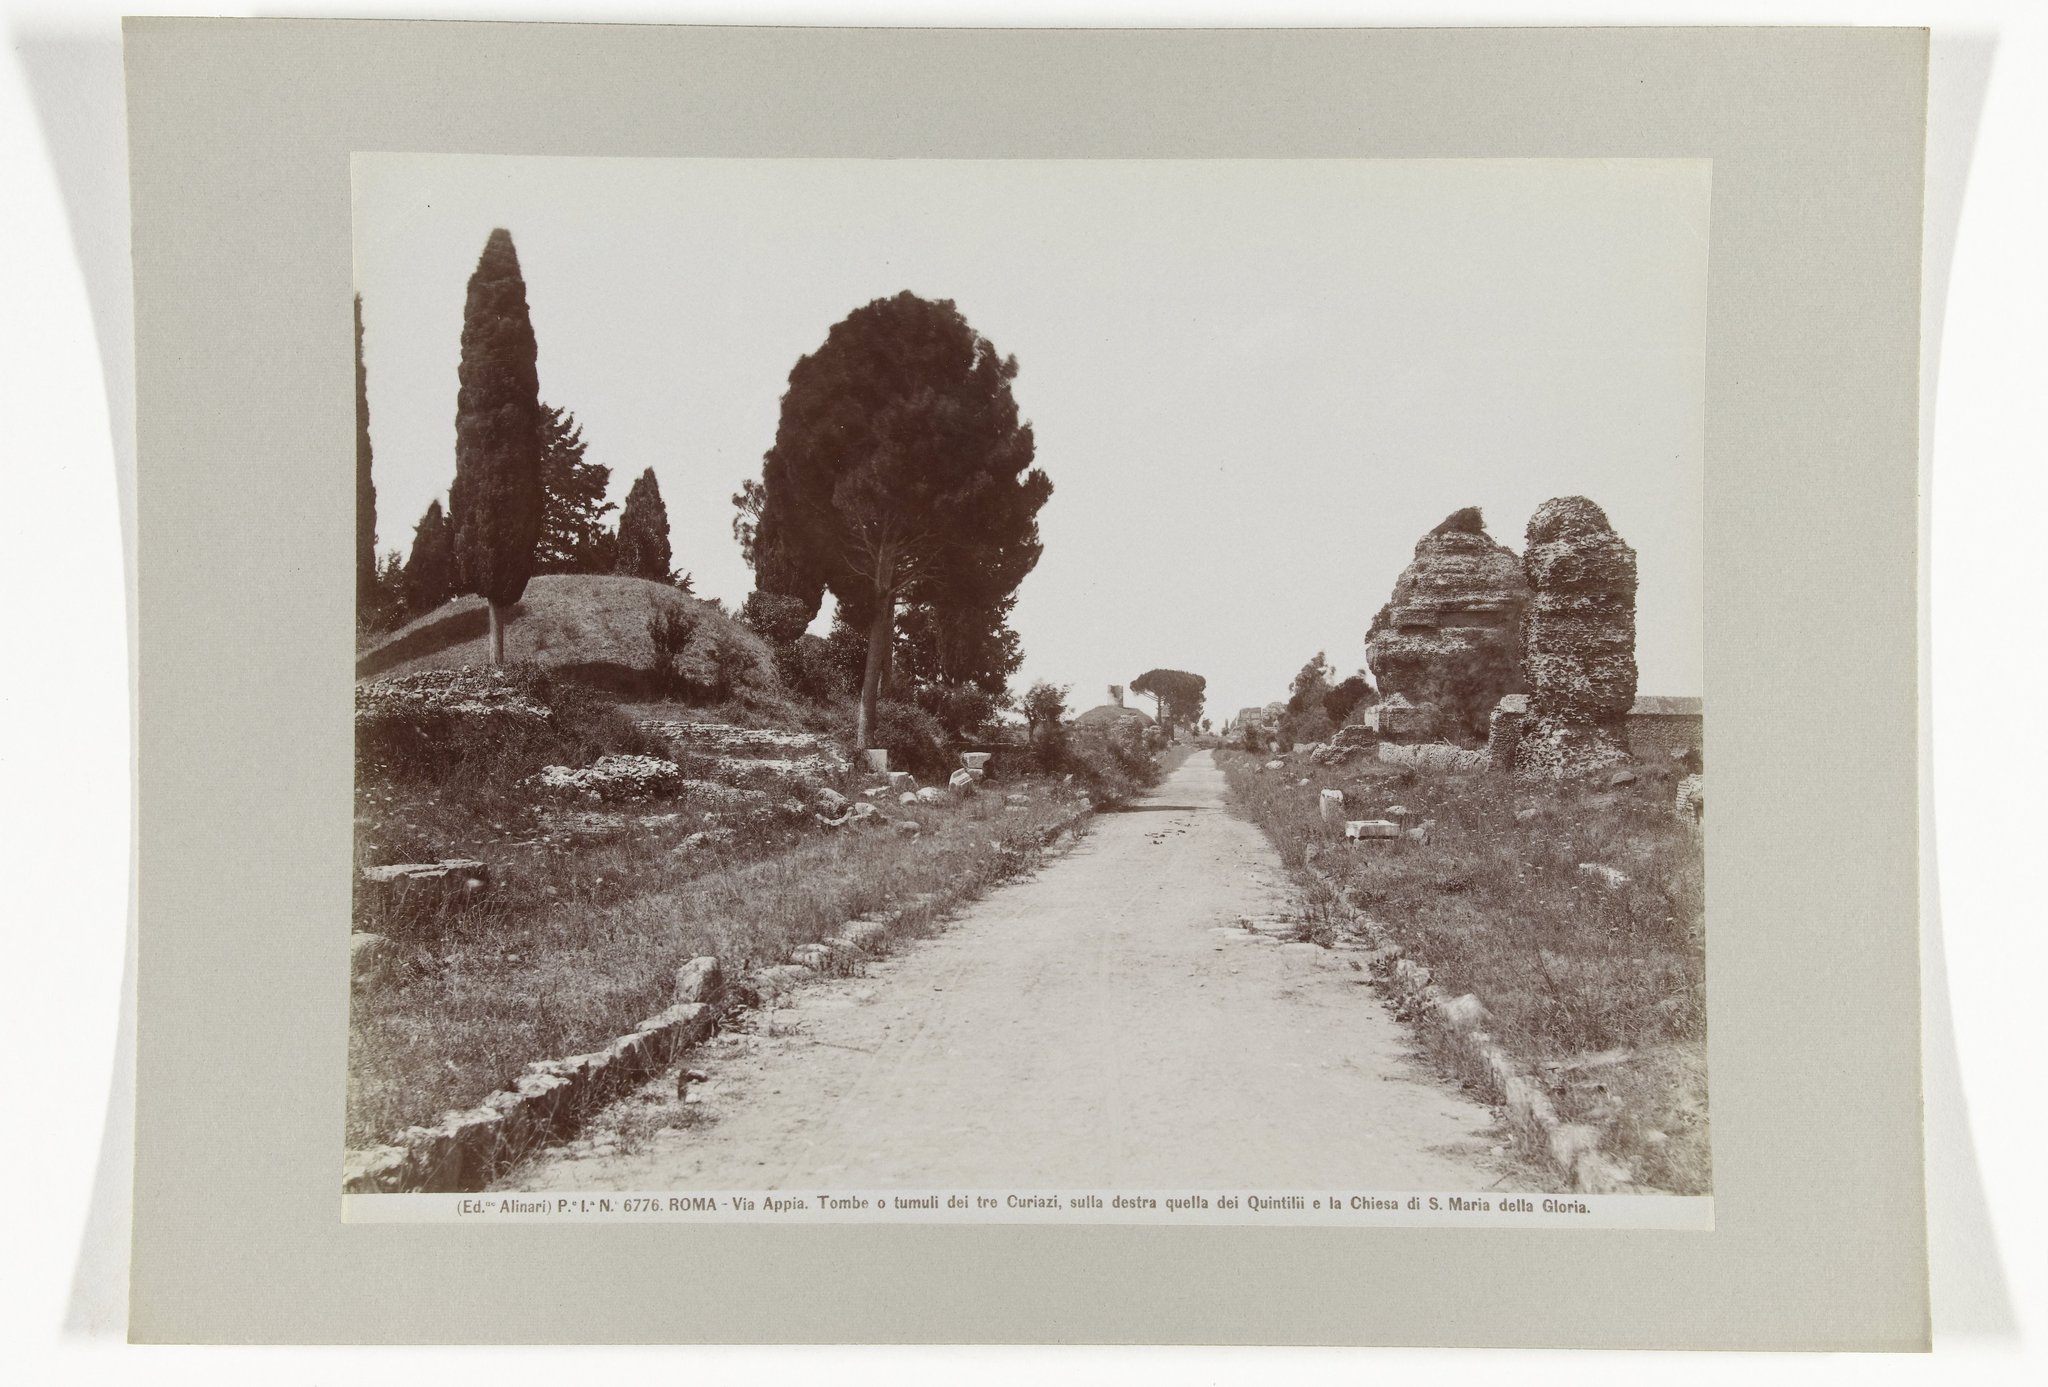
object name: photograph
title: P.e 1.a N.o 6776. ROMA - Via Appia. Tombe o tumuli dei tre Curiazi, sulla destra quella dei Quintilii e la Chiesa di S. Maria della Gloria.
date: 1880-1895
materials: cardboard, paper, photographic support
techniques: albumen print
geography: florence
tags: grave, tomb, road, path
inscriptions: number: ‘23.’